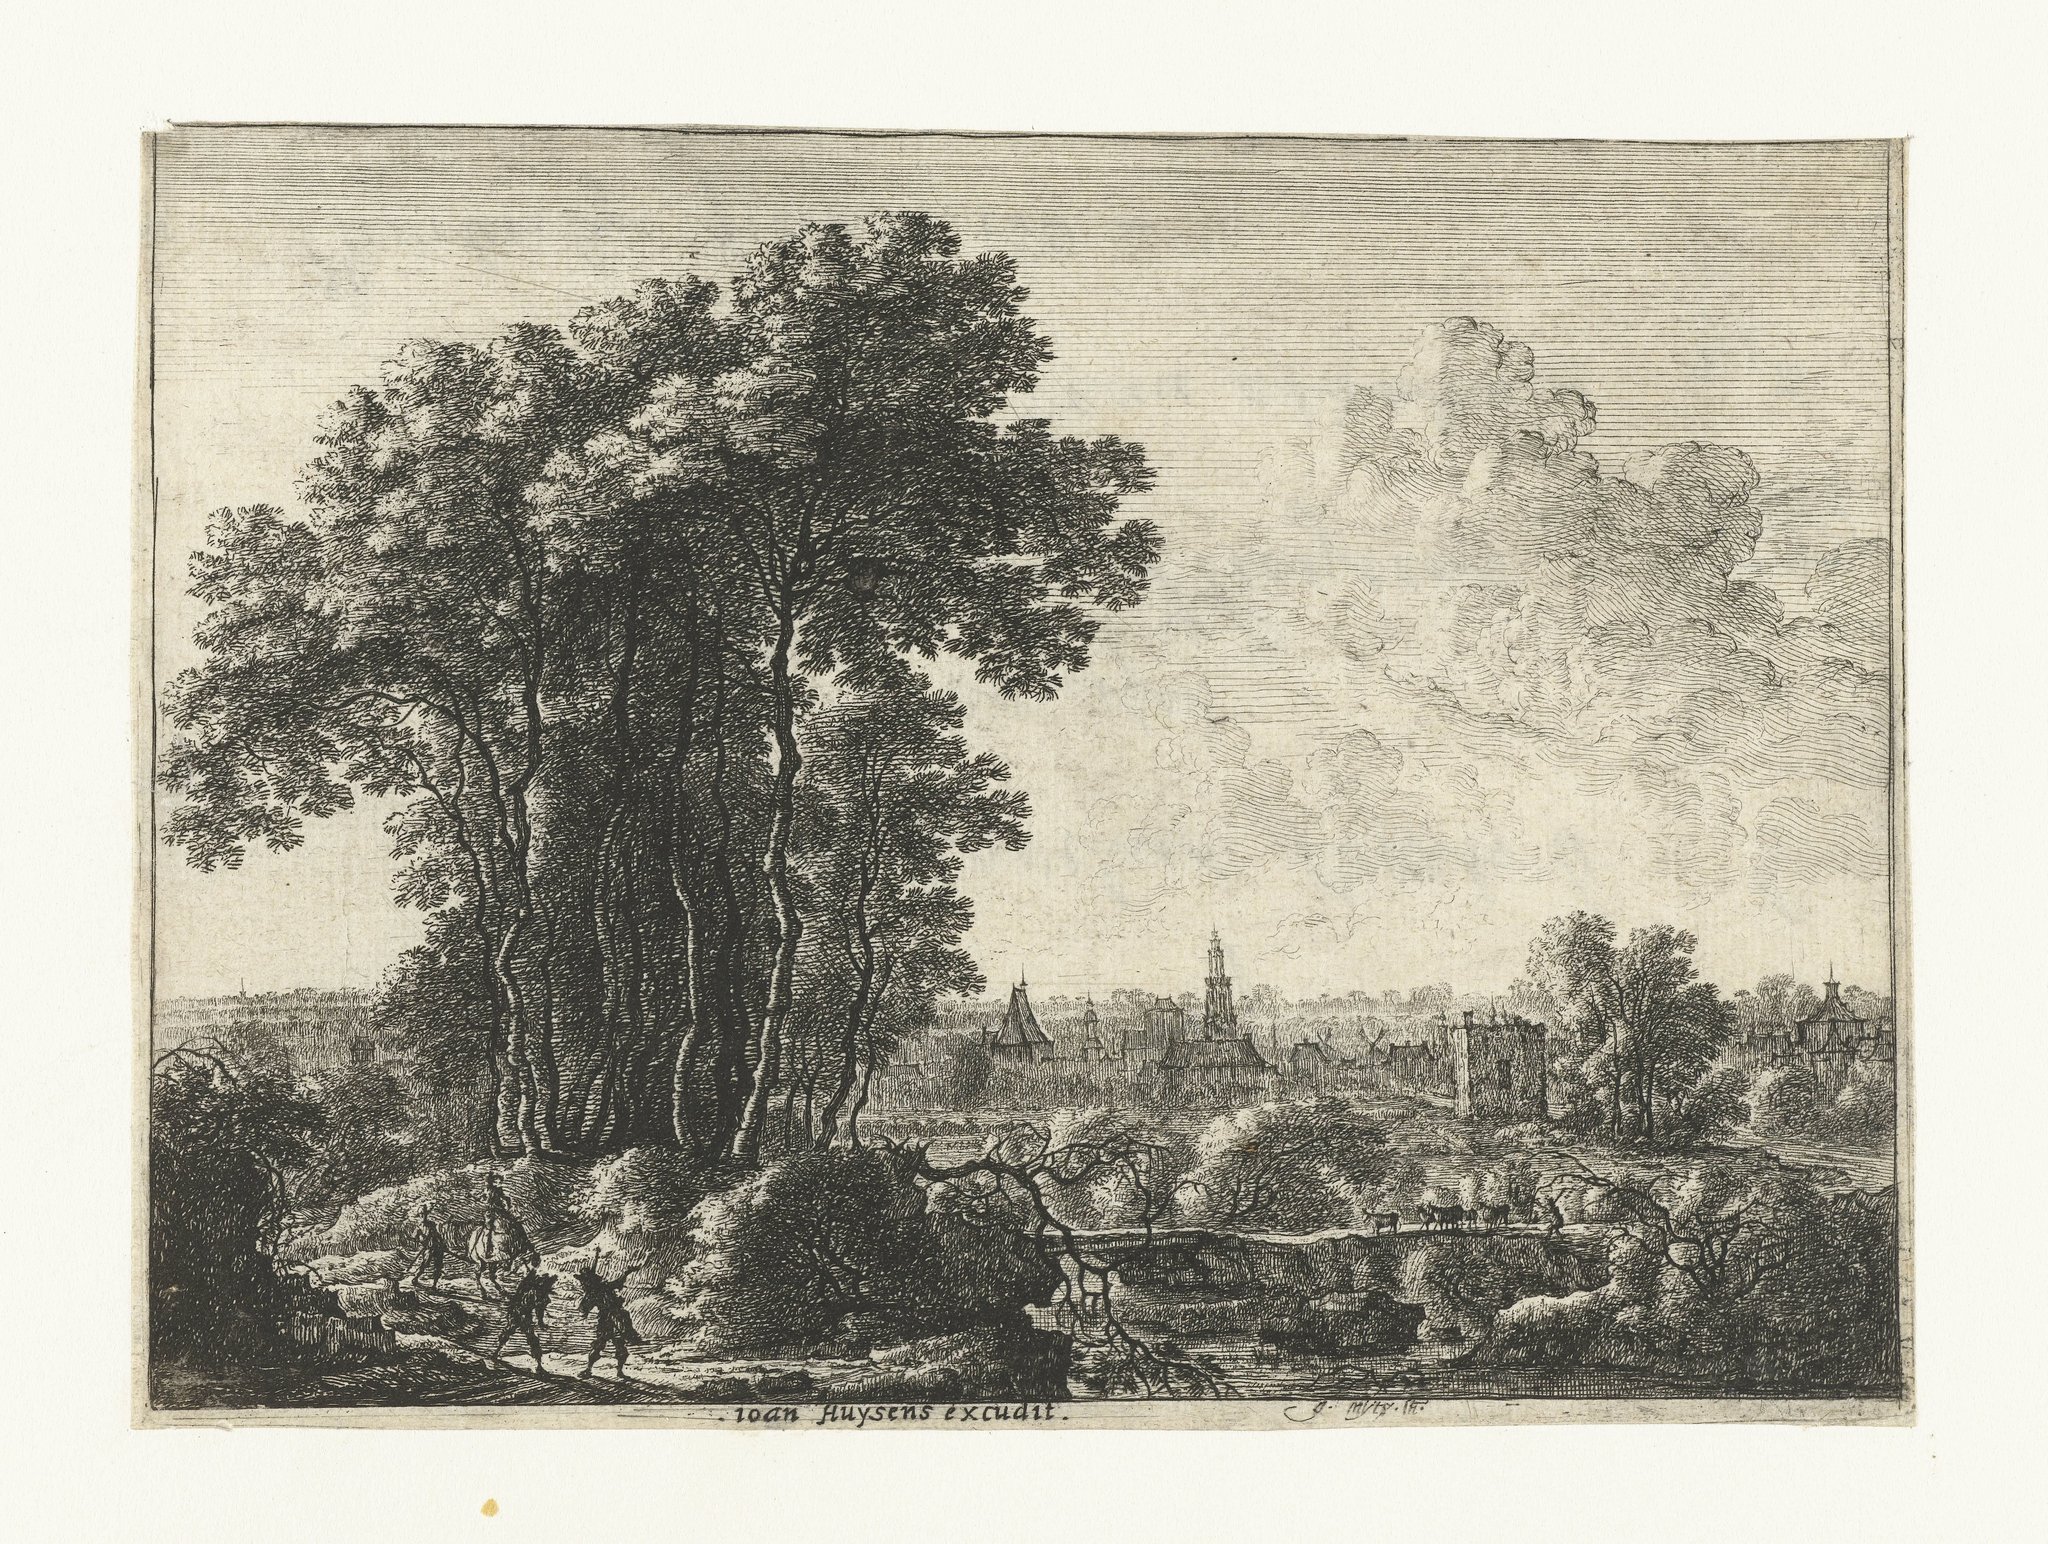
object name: print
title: Landschap met reizigers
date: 1643-1681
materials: paper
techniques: etching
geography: low countries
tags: landscapes in the temperate zone, landscape with bridge, viaduct or aqueduct, village, 'en route', traveller under way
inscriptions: collector's mark: Lugt 2228a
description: Een bosachtig landschap met een dorp aan een rivier. Op de voorgrond links drie reizigers te voet en één te paard.